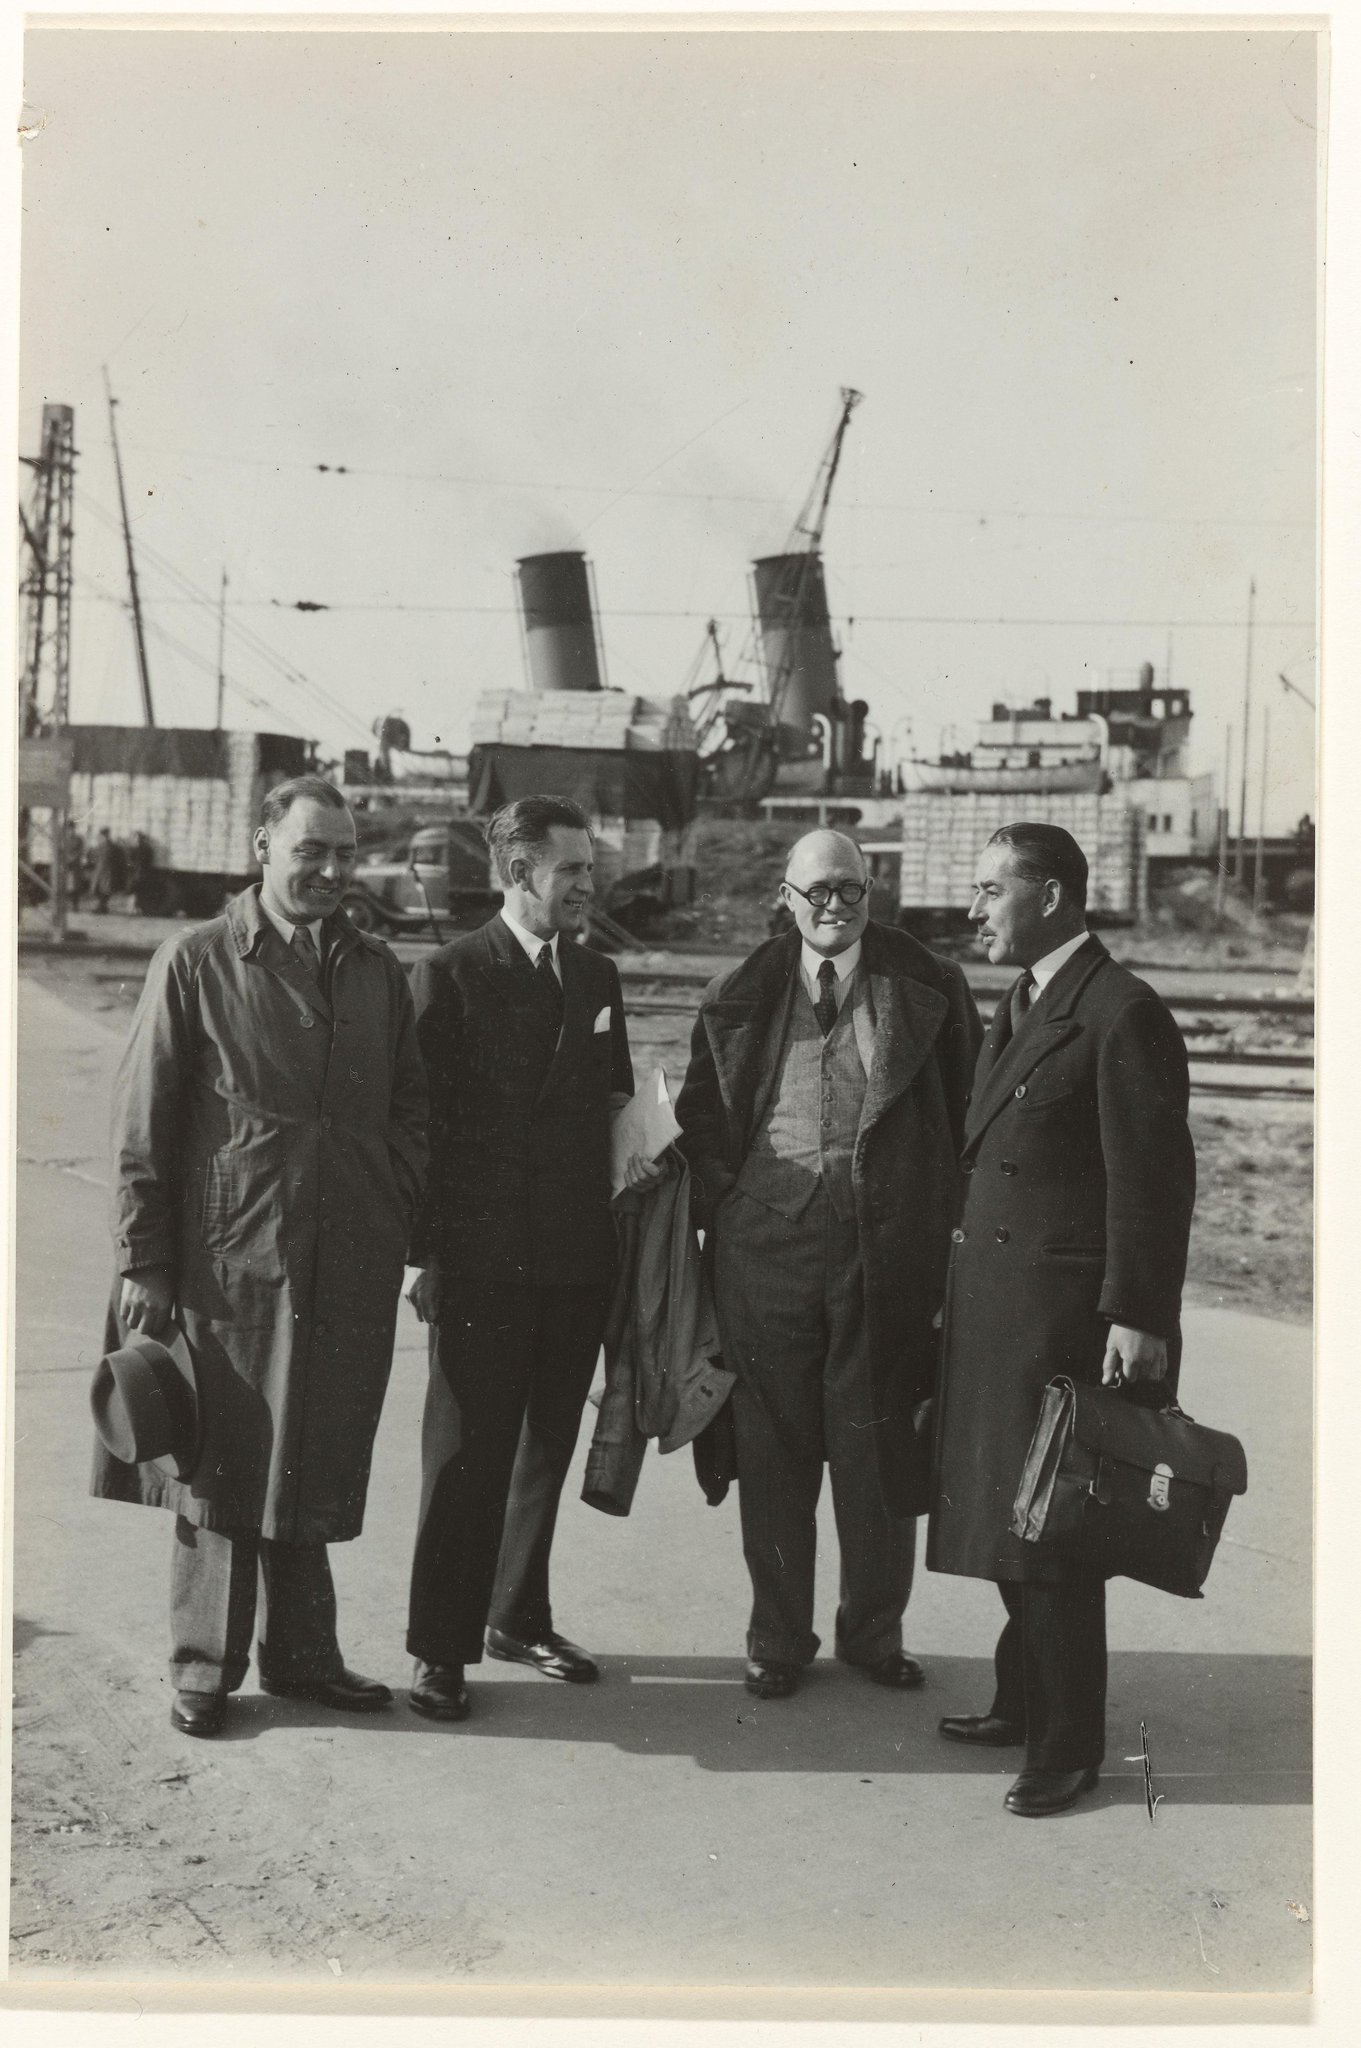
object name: photograph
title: Bezoek van vier leden van de BBC aan Nederland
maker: hof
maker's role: fotograaf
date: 1945-1946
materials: photographic support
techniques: photography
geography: hoek van holland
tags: british broadcasting corporation, hoek van holland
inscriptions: inscription, stamp: ‘COPYRIGHT / 'ANEFO' / ALGEMEEN NEDERLANDSCH FOTOBUREAU’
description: Bezoek van vier leden van de BBC aan Nederland.